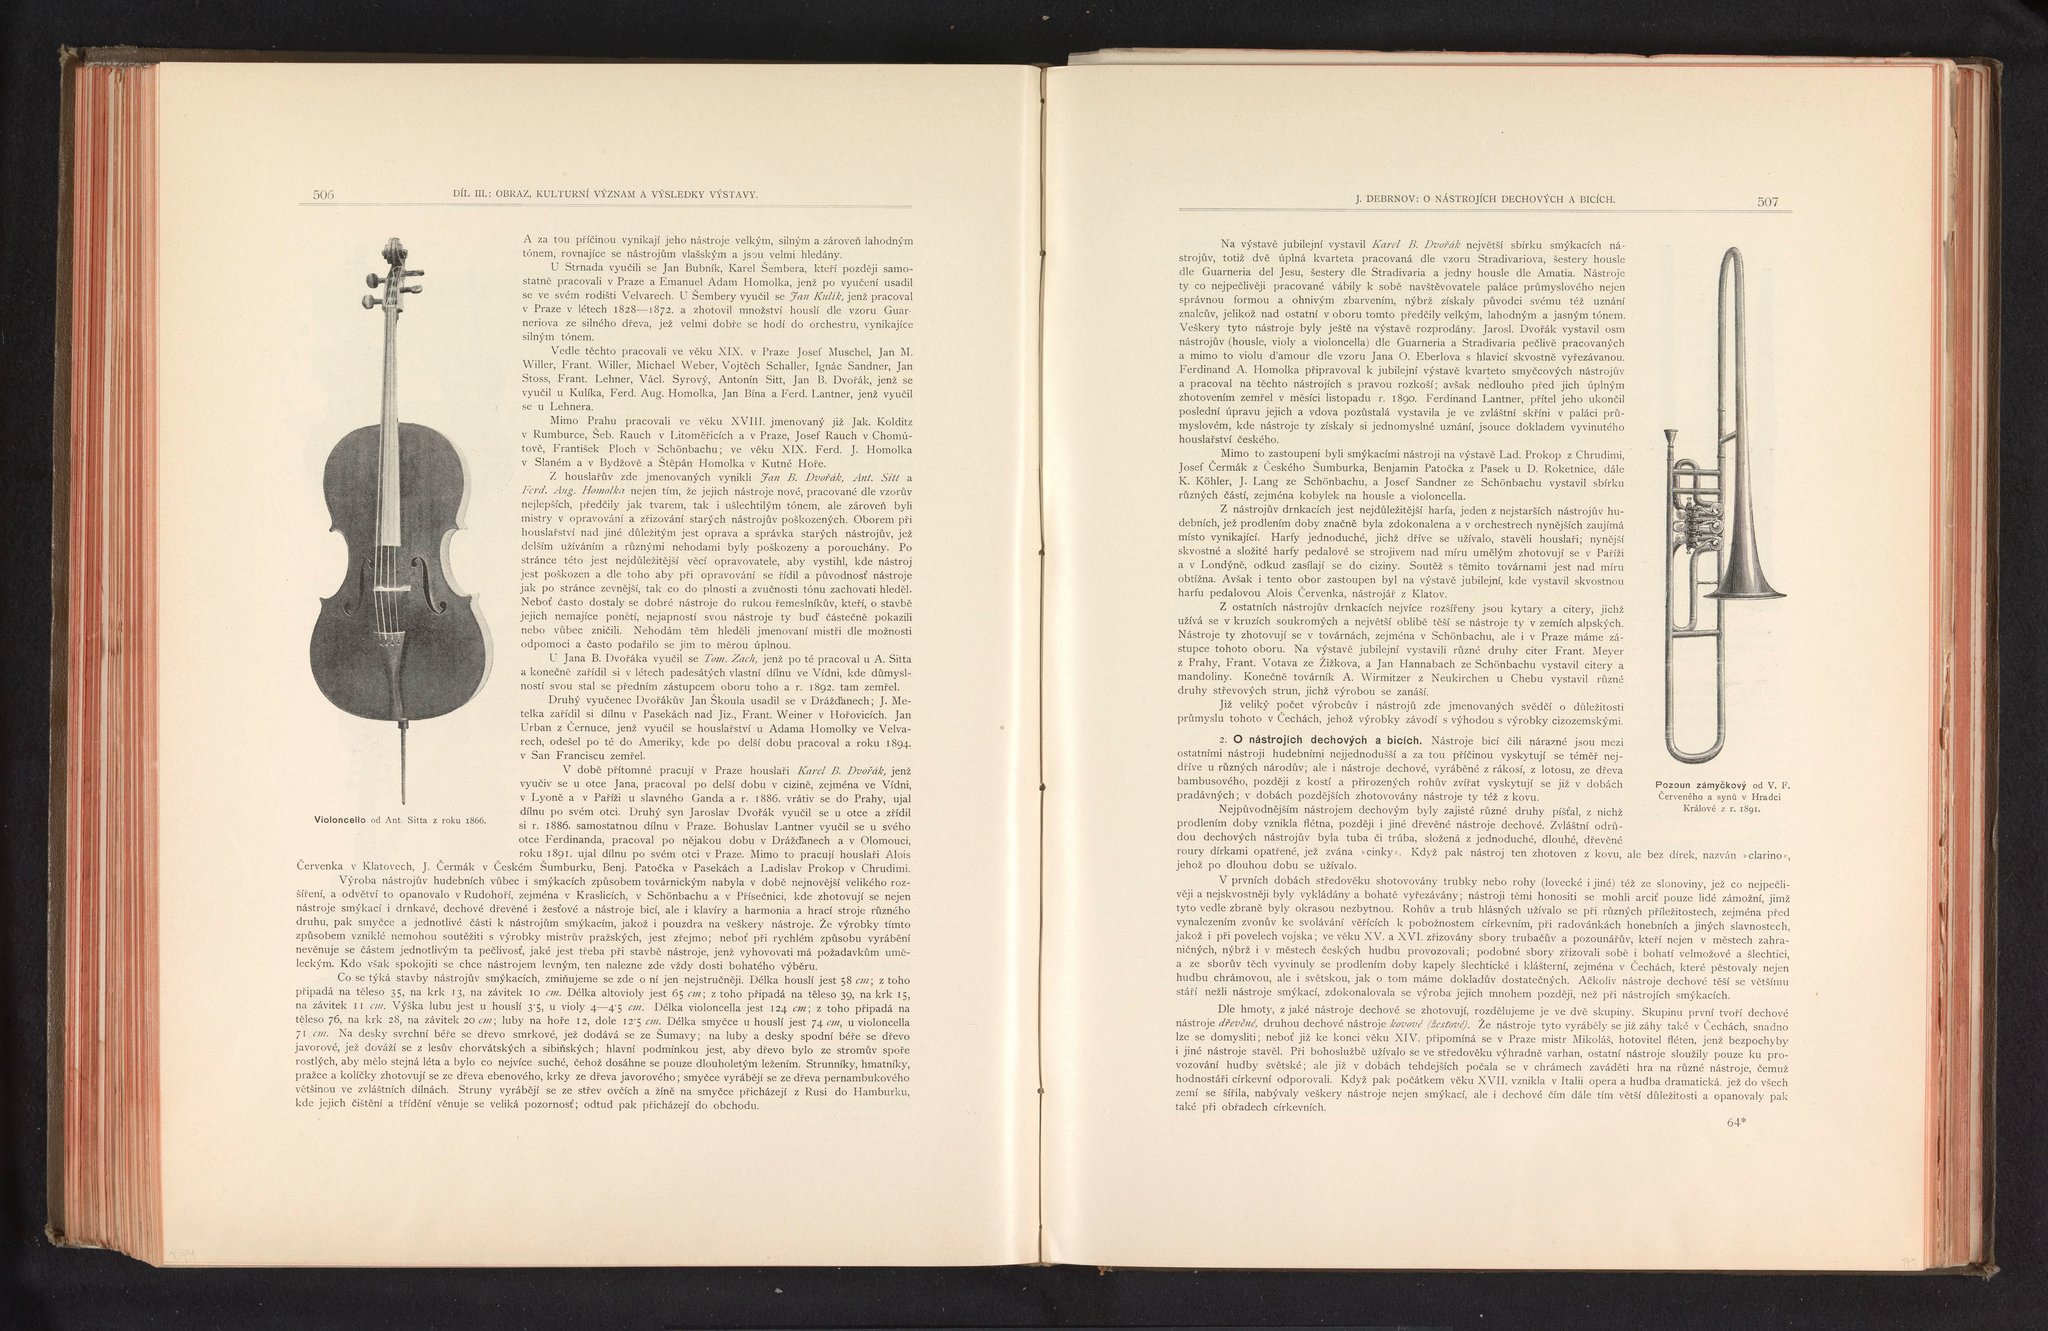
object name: page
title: Cello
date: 1891-1895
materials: paper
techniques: autotype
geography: prague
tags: viola, violoncello; double bass